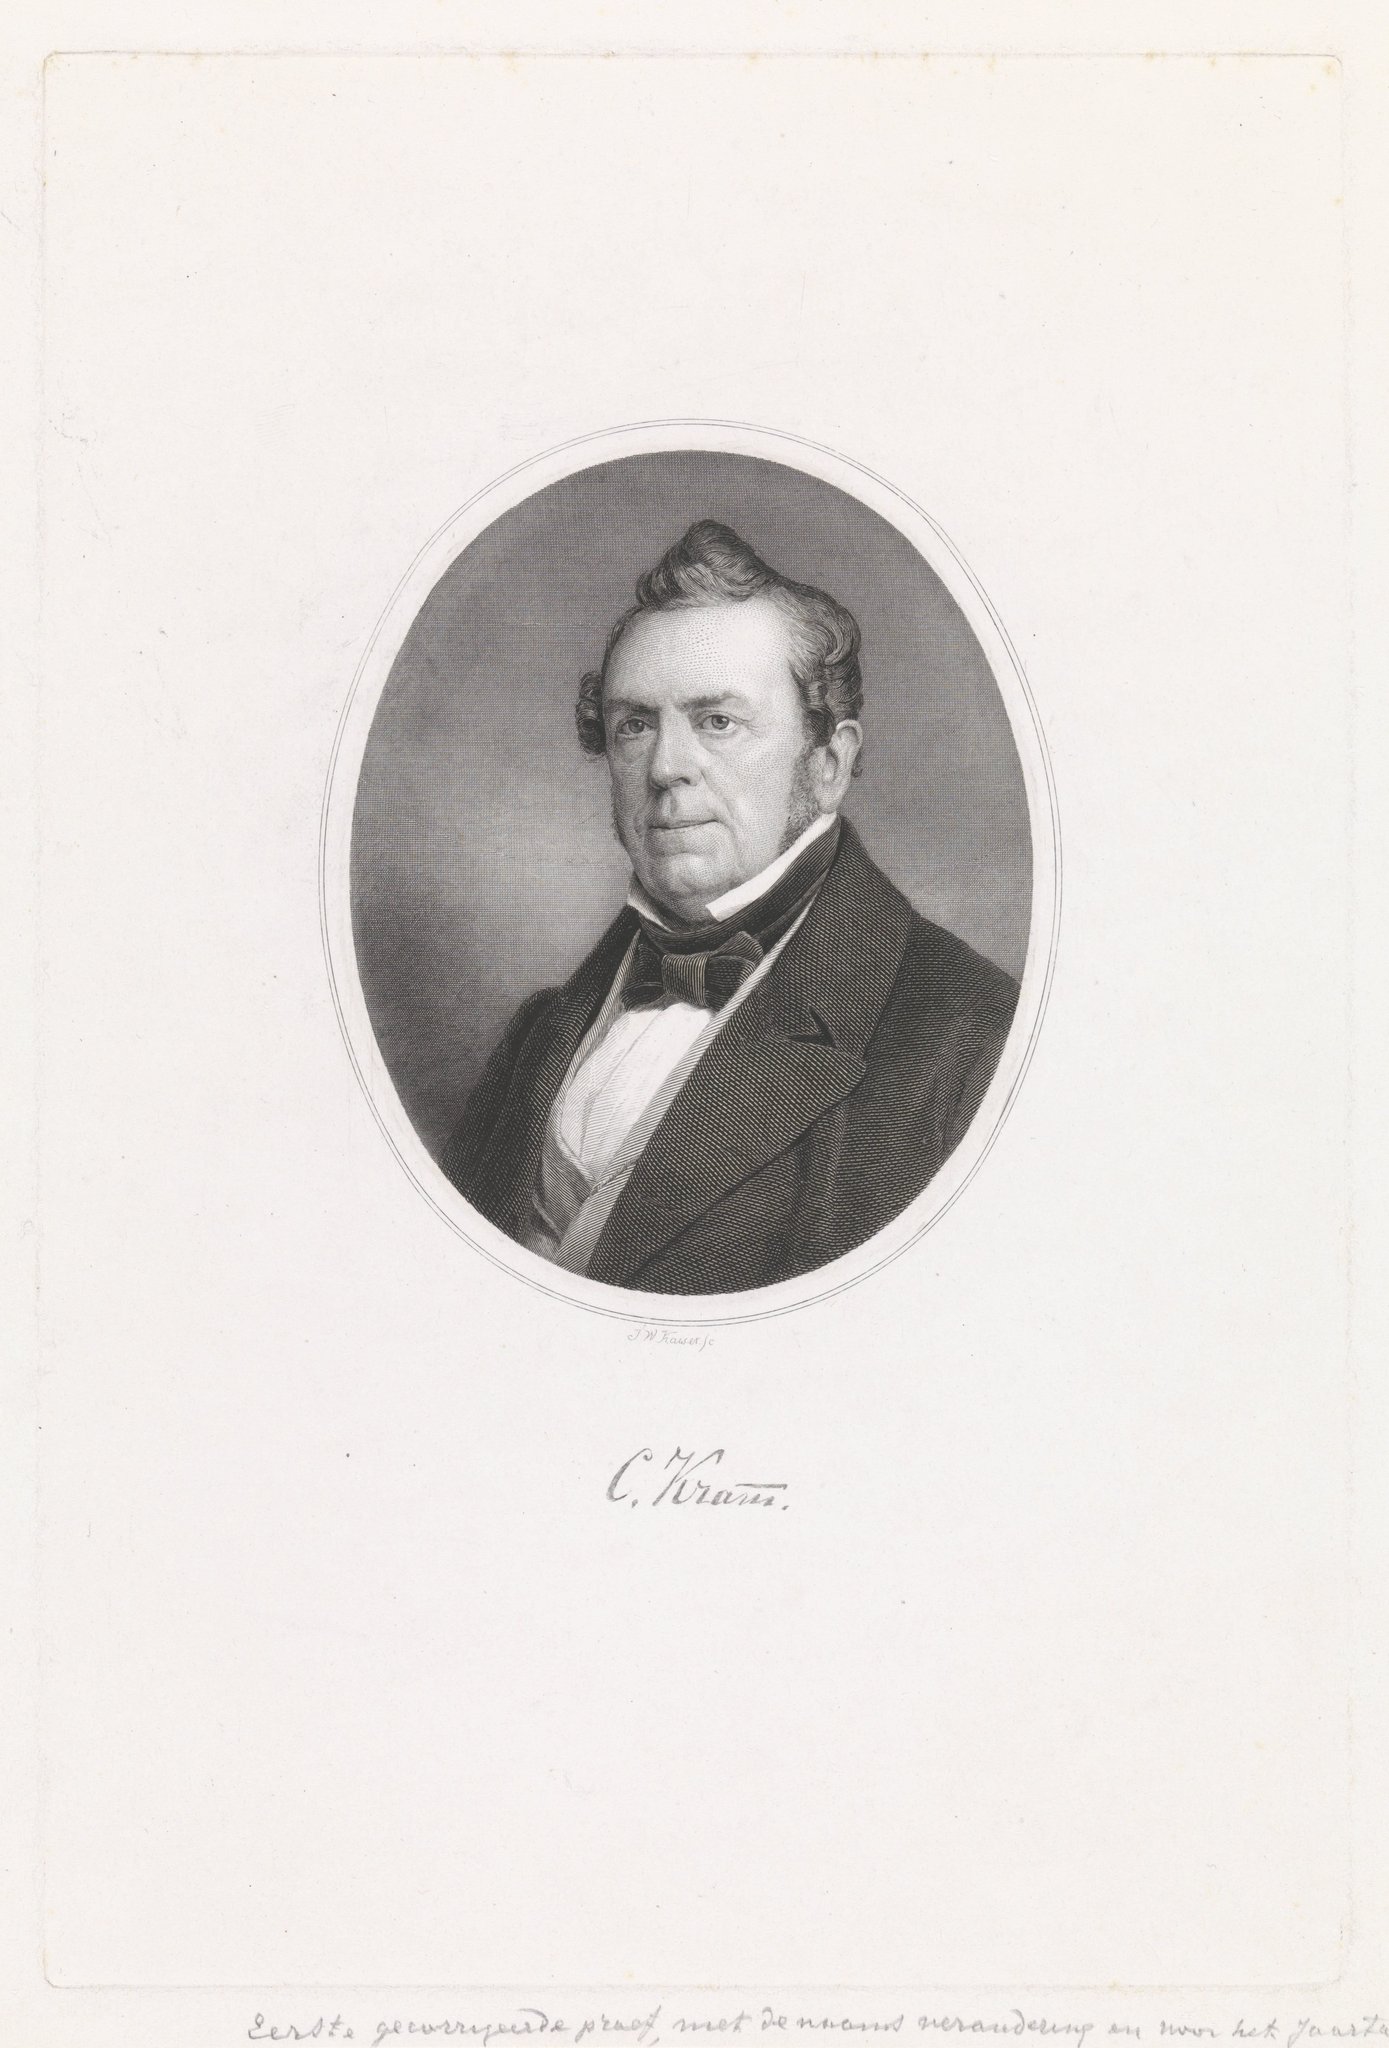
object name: print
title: Portret van Christiaan Kramm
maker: johann wilhelm kaiser (i)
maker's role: draughtsman, print maker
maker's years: 1813-1900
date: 1864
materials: paper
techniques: etching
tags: utrecht, print maker, draughtsman, christiaan kramm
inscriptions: inscription: ‘Eerste gecorrigeerde proef, met de naams verandering en voor het jaartal’, collector's mark: Lugt 2228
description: Portretbuste in ovaal naar links van schrijver en beeldend kunstenaar Christiaan Kramm.